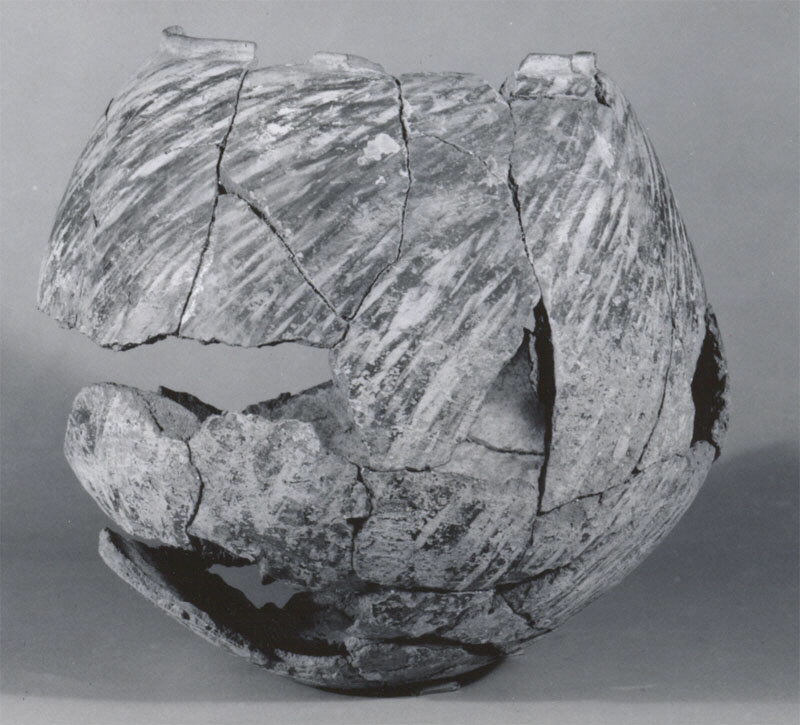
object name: pot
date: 5000-4001 BCE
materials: ceramic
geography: iran